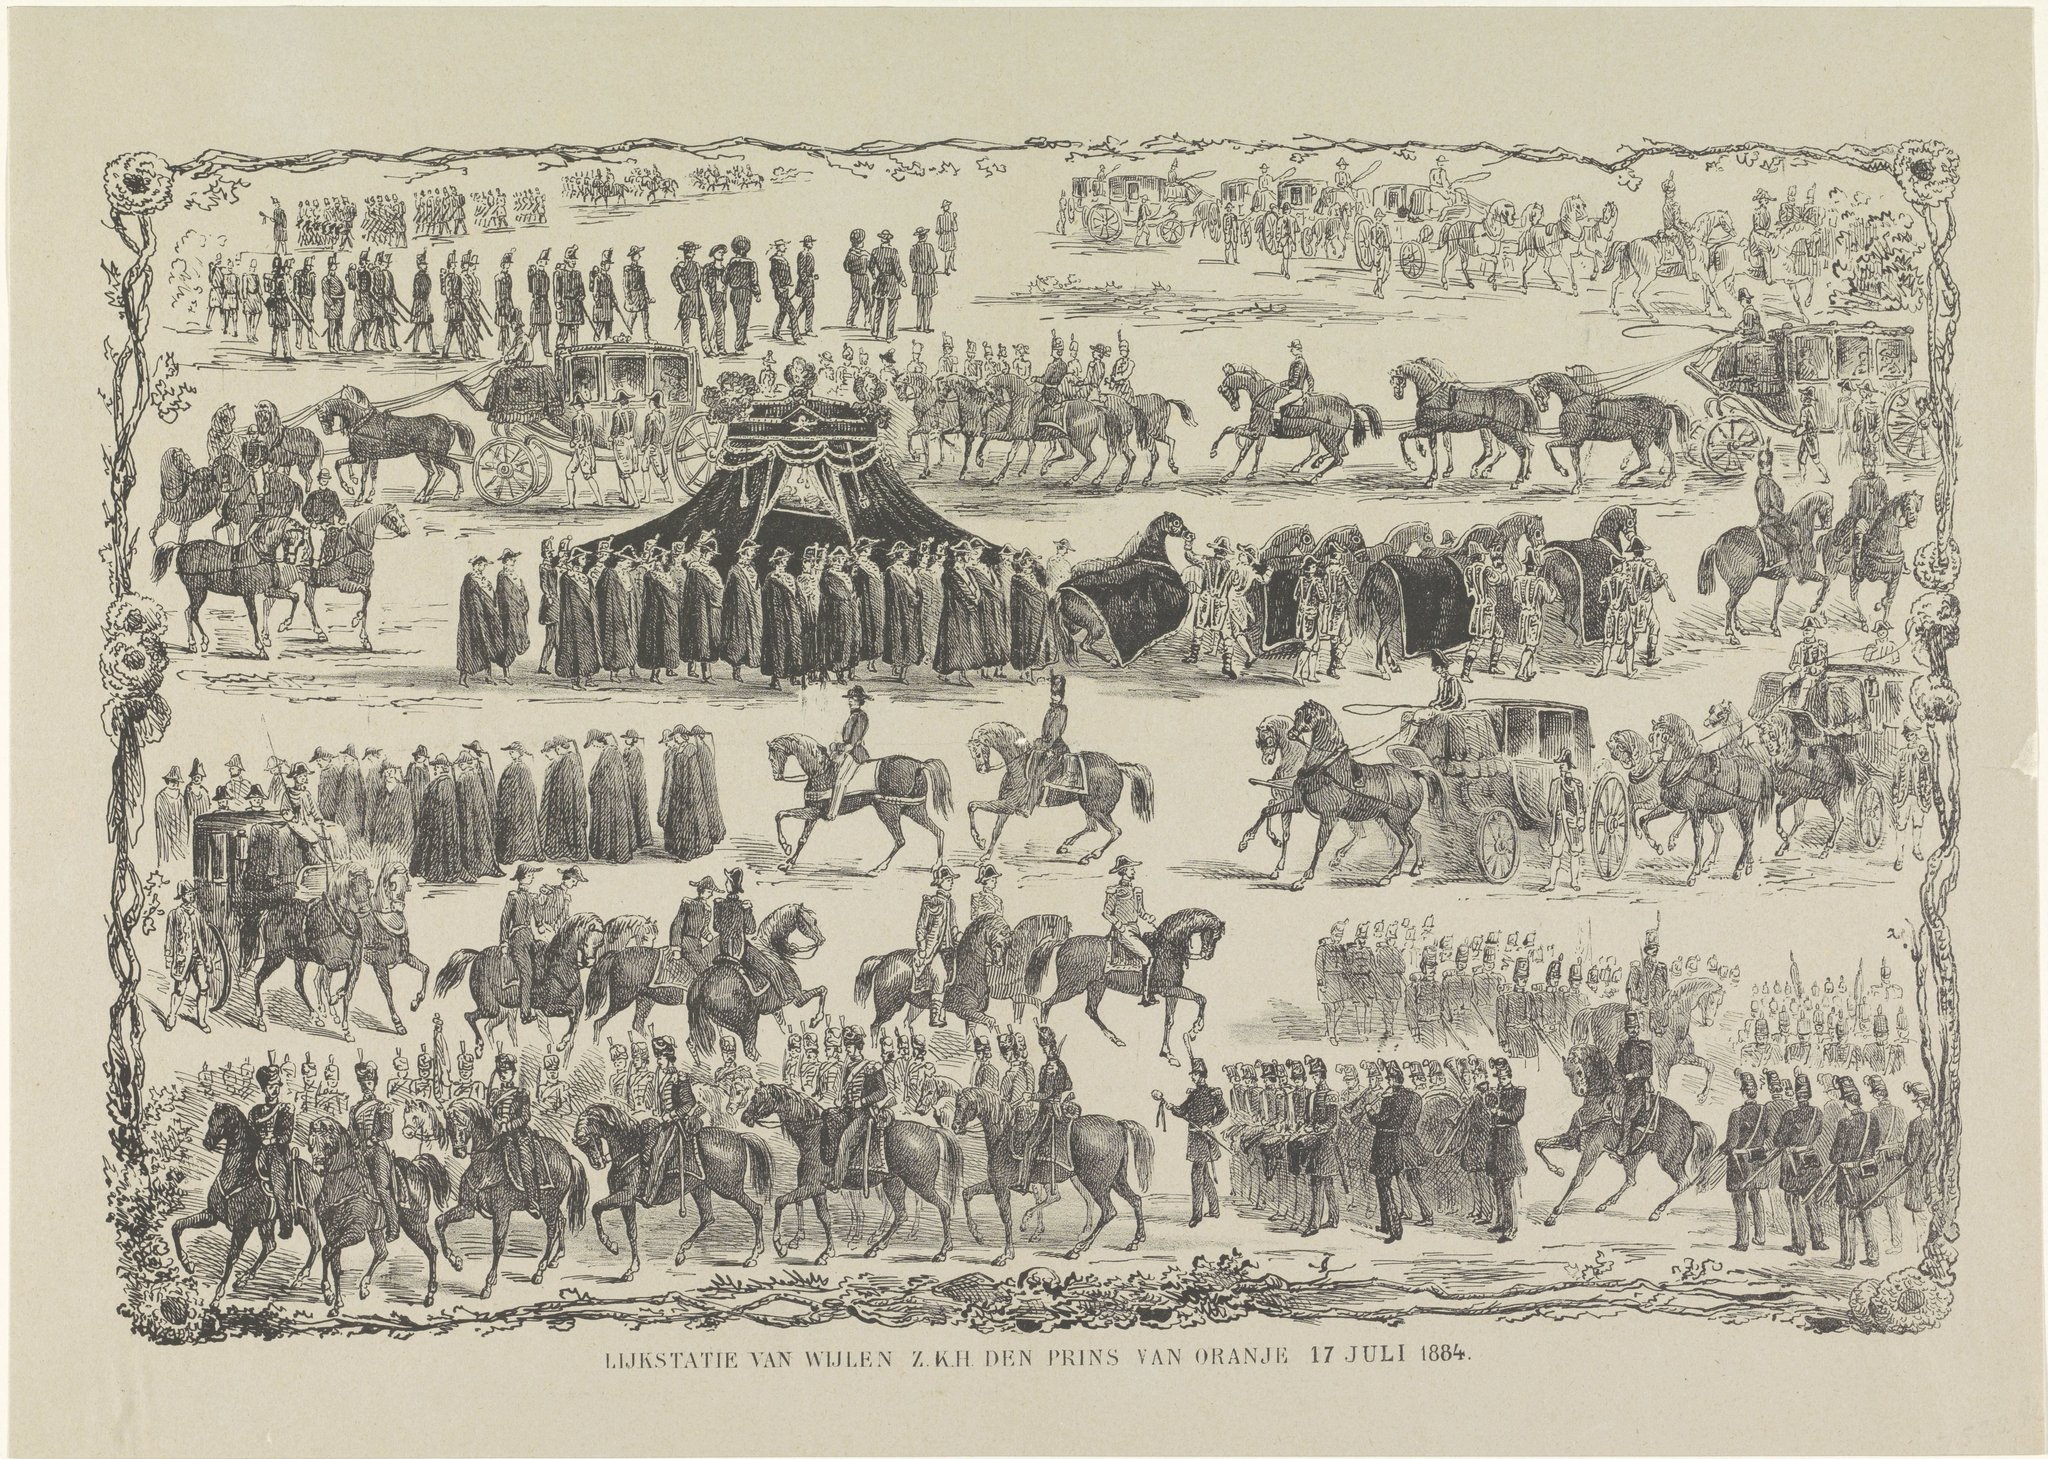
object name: print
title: Lijkstatie van wijlen Z.K.H. den prins van Oranje 17 Juli 1884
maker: Anonymous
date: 1884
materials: paper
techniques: lithograph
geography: netherlands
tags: the hague, cortege, funeral procession, delft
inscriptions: collector's mark: Lugt 2228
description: Begrafenisstoet van de overleden Prins Alexander van Oranje-Nassau, te Delft op 17 juli 1884. De stoet afgebeeld in zes rijen onder elkaar.